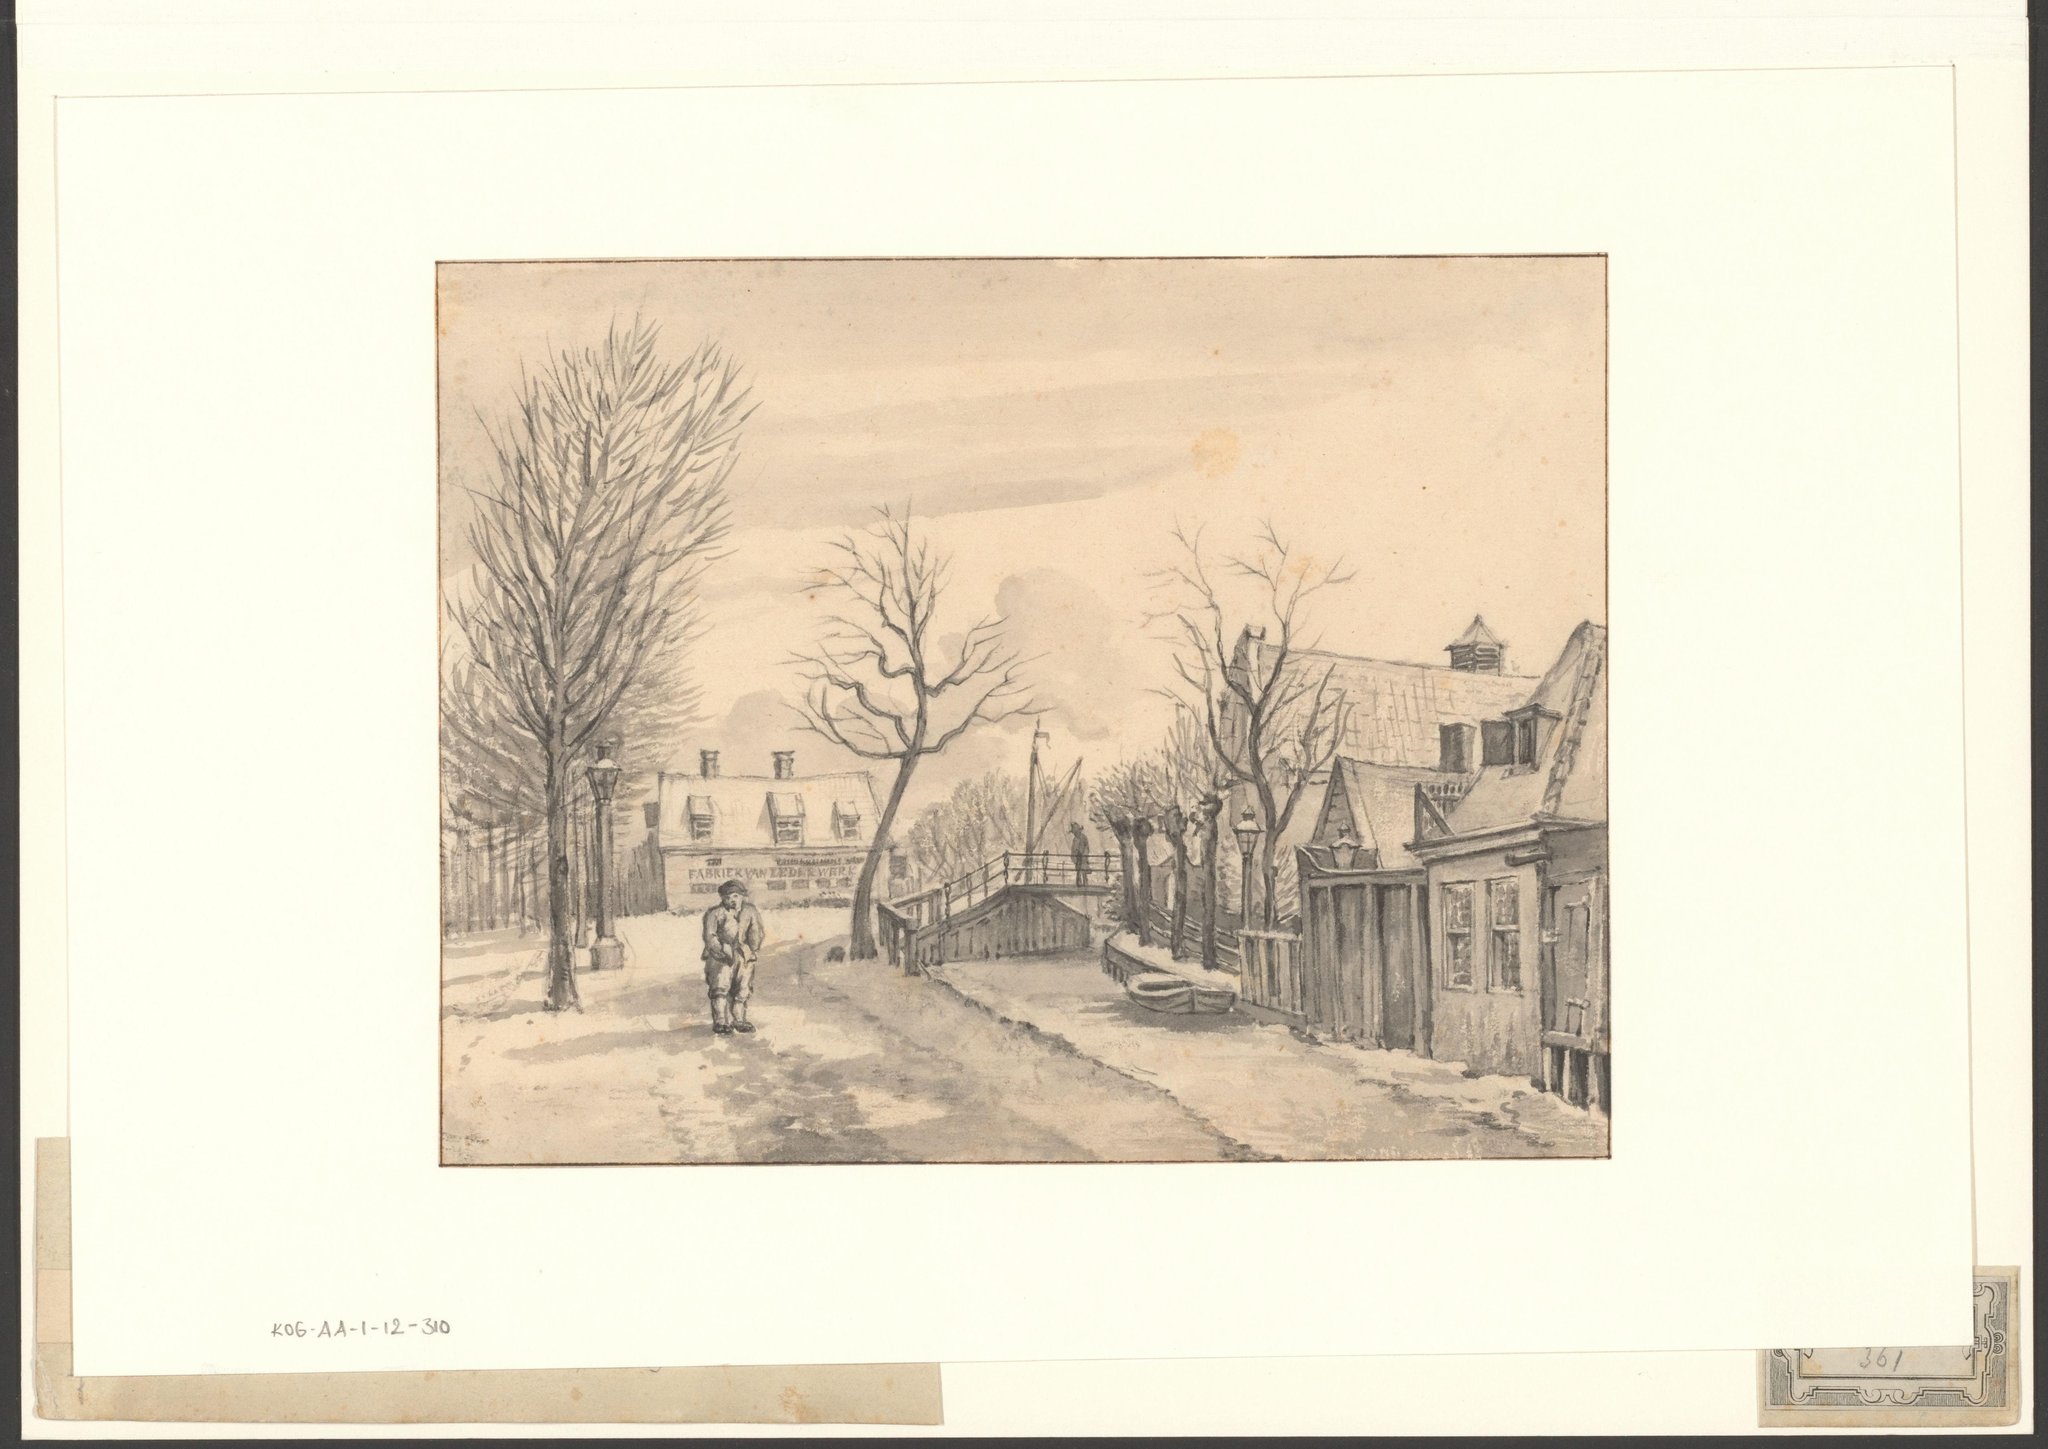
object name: drawing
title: Gezicht op het Drilveld, gezien vanaf de Schans bij de Reguliersgracht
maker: gerrit lamberts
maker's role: bookseller, draughtsman, print maker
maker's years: 1776-1850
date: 1817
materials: chalk, ink, paper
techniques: brush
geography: amsterdam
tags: artillery range, firing range, shooting range ~ military training, city-view in general; 'veduta'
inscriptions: collector's mark: ‘12’ Lugt 1641b, inscription: ‘binnen de stad (...) g. Lamberts getekend.’, inscription: ‘361 Gezicht van (...) 16, B.20,5’, collector's mark: ‘361’ Lugt 1811, inscription: ‘Port. 12-310’, signature, date and inscription: ‘Gezigt aan de Schan bij de Reguliers / Gragt / G. Lamberts. 1817.’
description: Onderwerpsrubriek binnen de Atlas Amsterdam: Sarphatistraat, Schans.